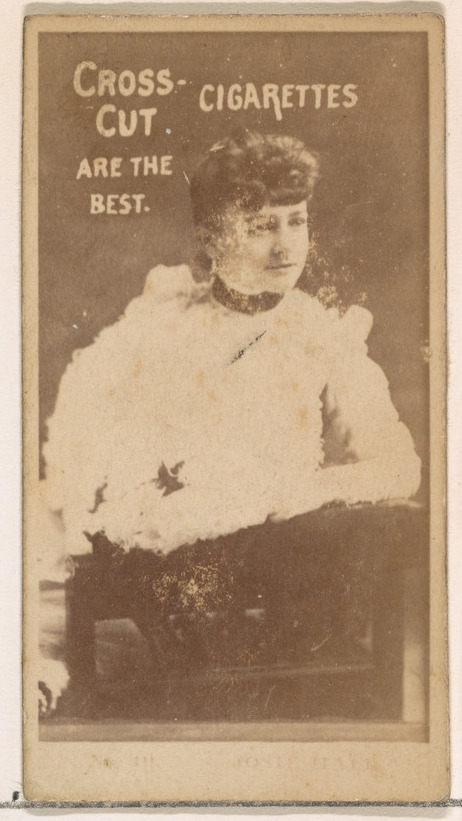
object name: print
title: Josie Hall, from the Actors and Actresses series (N145-2) issued by Duke Sons & Co. to promote Cross Cut Cigarettes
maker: w. duke, sons & co.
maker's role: publisher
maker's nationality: american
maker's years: 1870-1920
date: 1880-1889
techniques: albumen silver print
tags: portraits,women,actresses